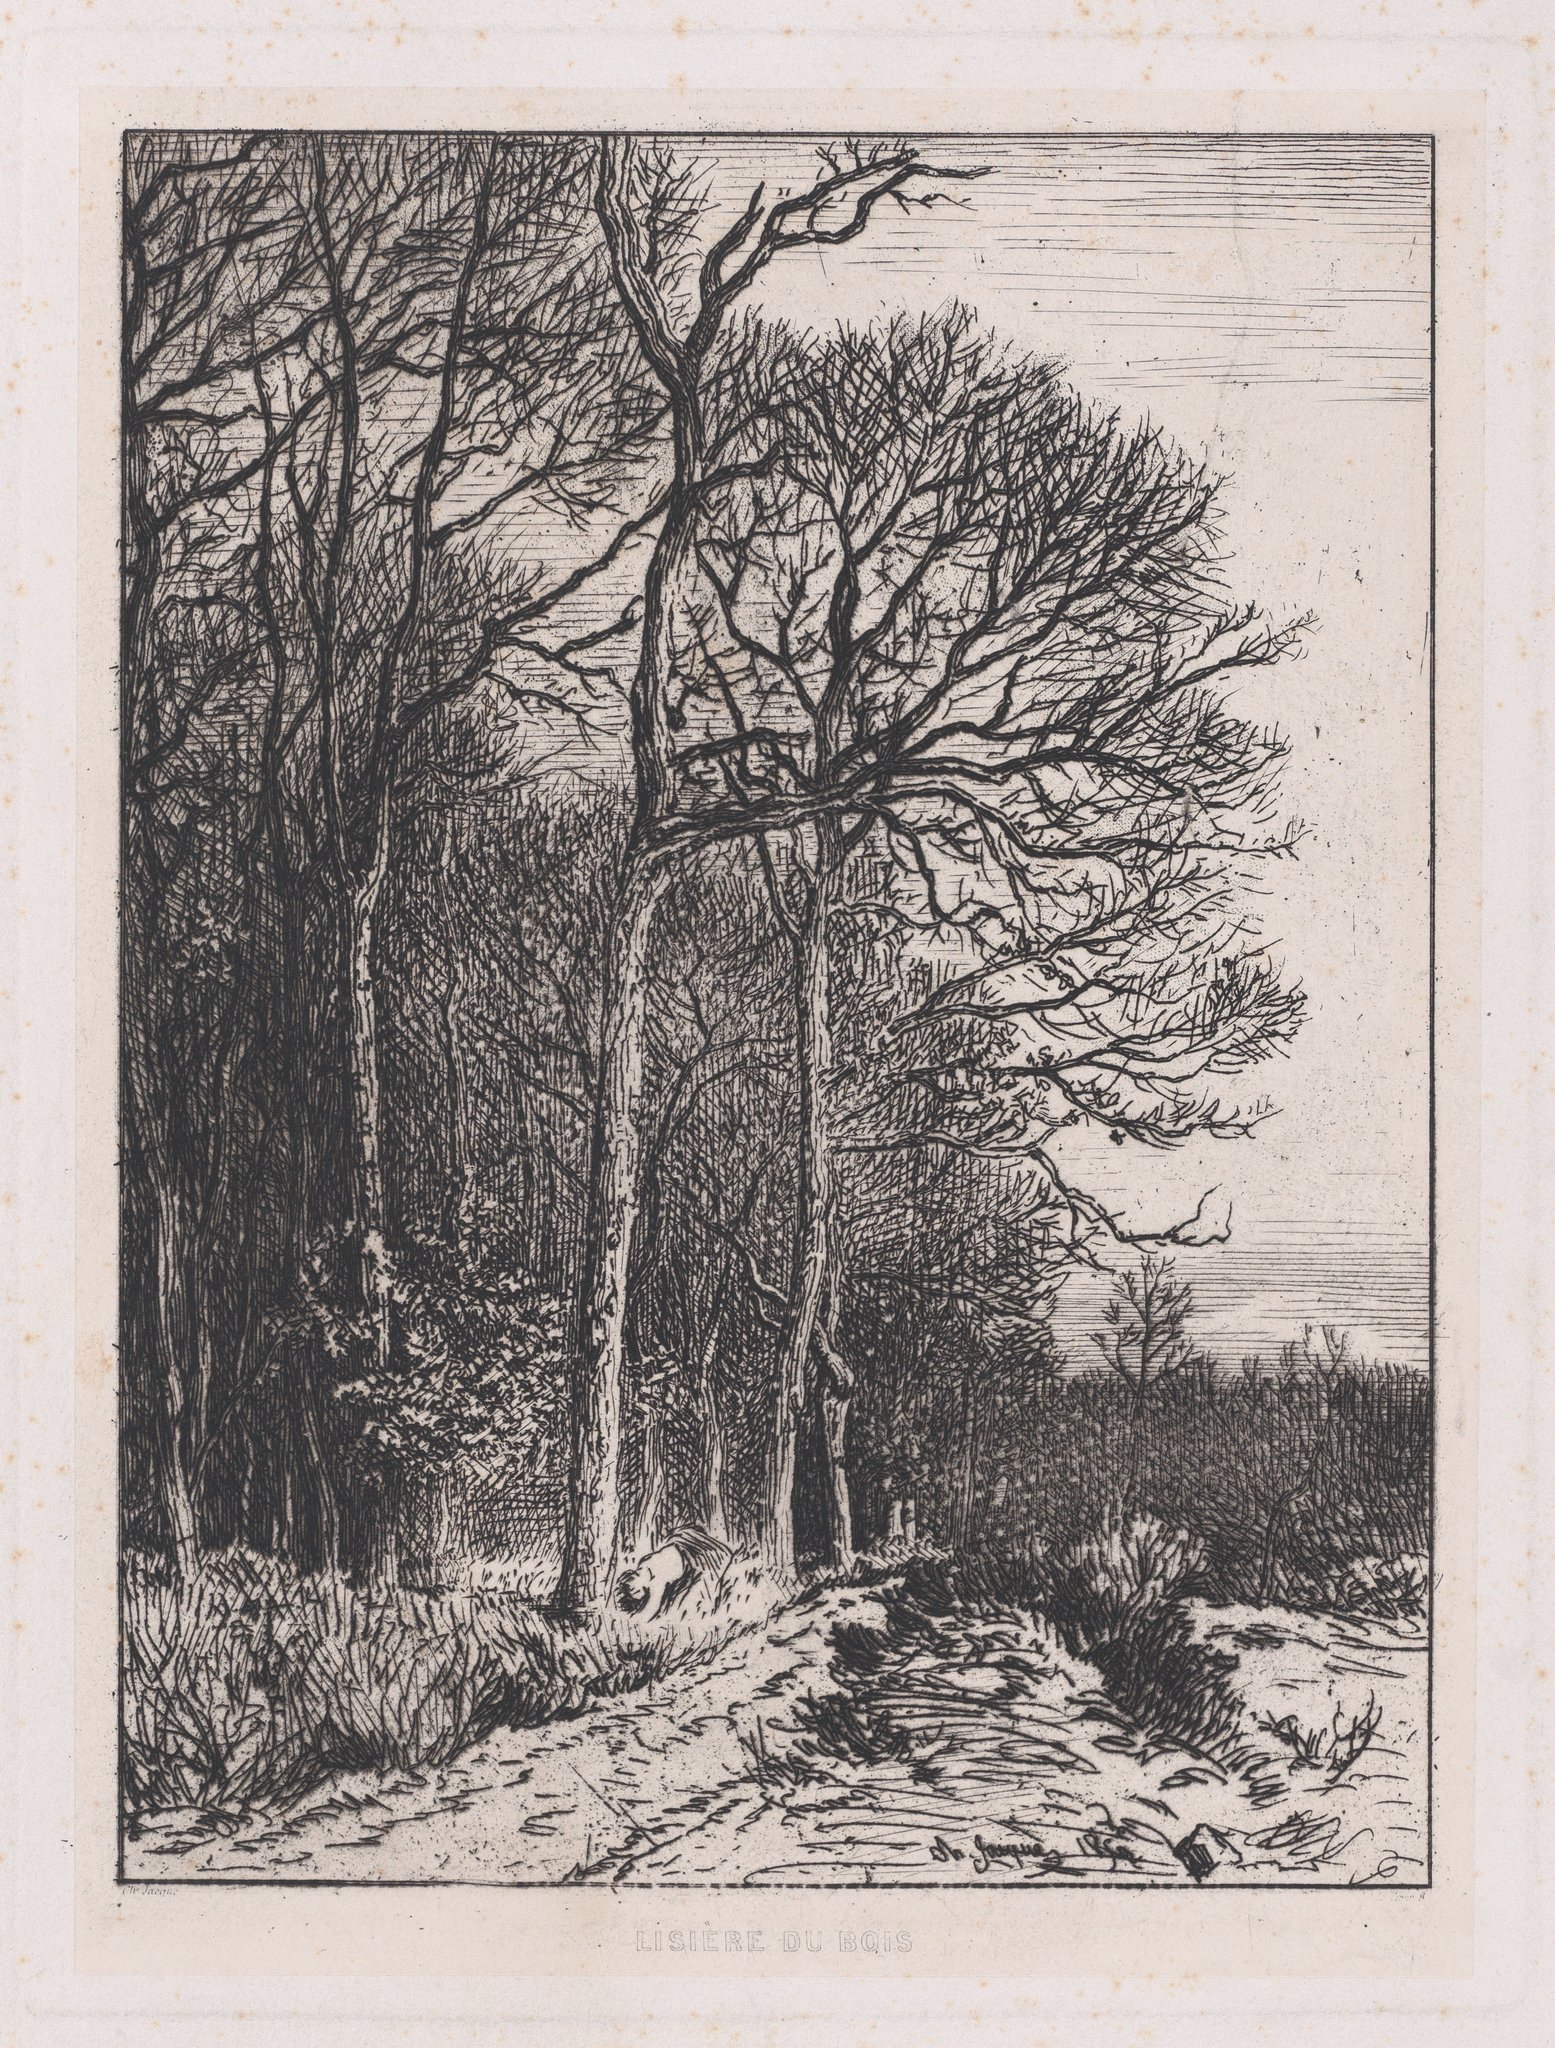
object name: print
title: Lisière du Bois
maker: charles émile jacque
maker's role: artist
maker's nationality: french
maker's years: 1813-1894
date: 1846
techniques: etching